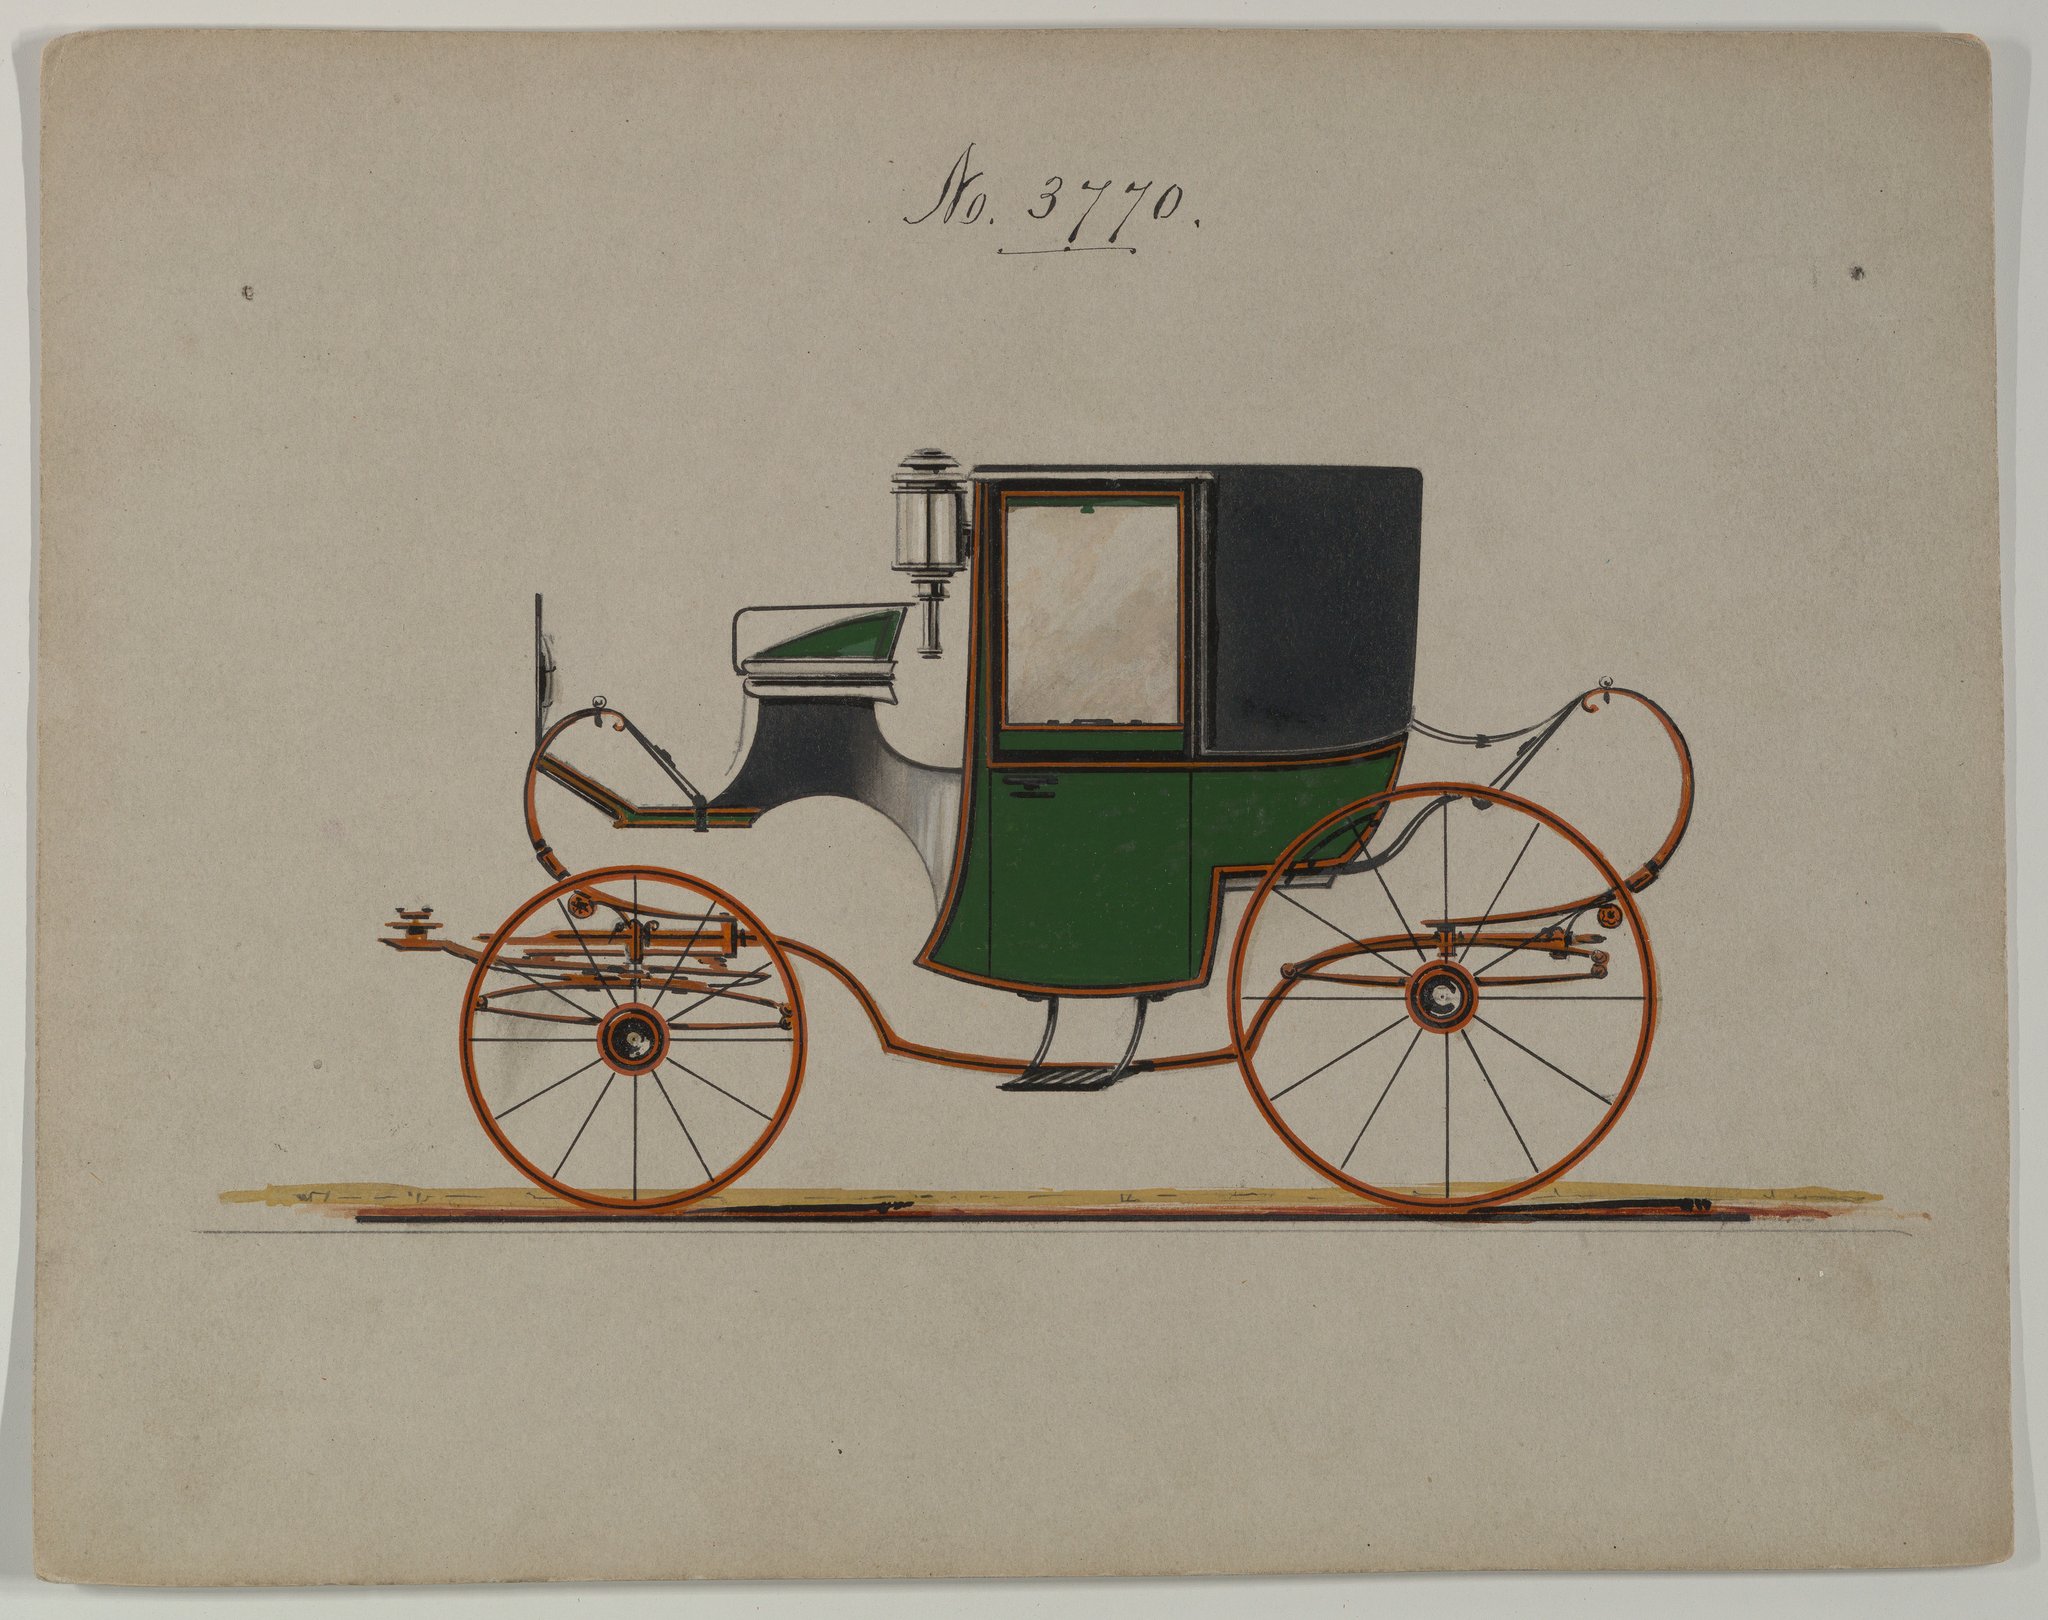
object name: drawing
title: D'Orsay #3770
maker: brewster & co.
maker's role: manufacturer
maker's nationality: american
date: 1882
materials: gouache, gum arabic, ink, watercolor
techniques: pen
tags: carriages